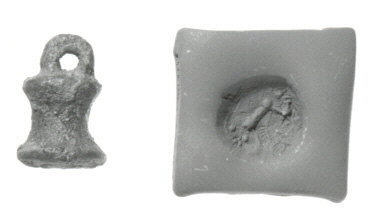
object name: stamp seal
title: Stamp seal (bell-shaped with loop handle) with monster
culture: urartian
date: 800-601 BCE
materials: alloy, bronze, copper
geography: urartu